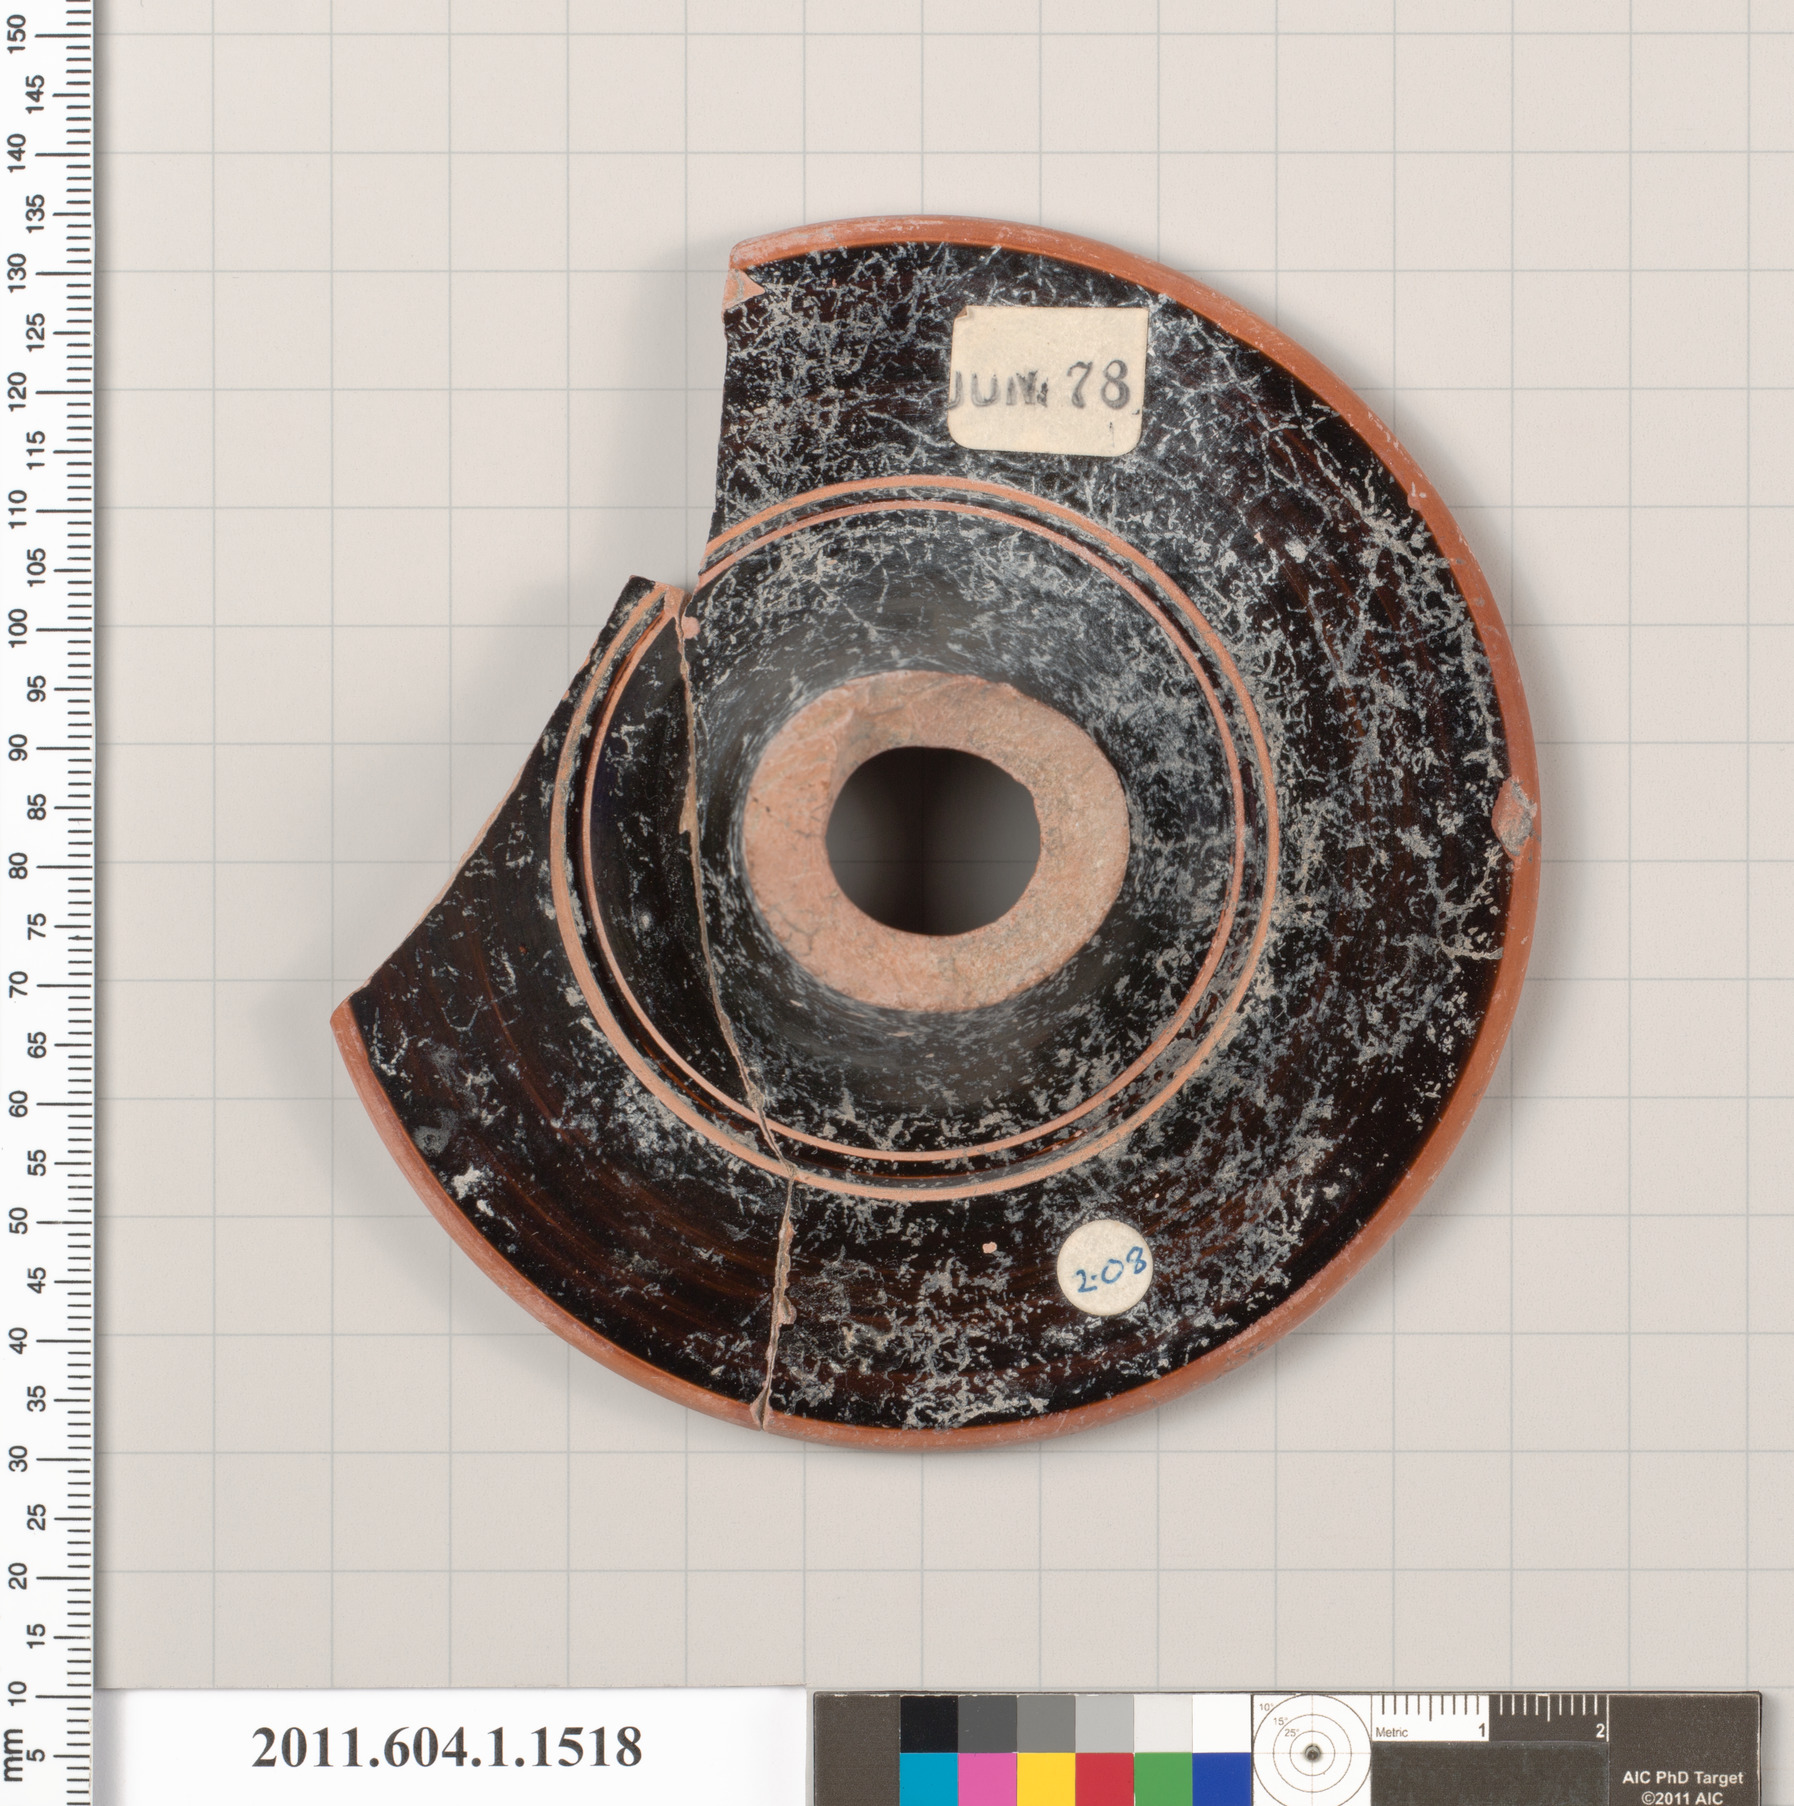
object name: kylix fragment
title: Terracotta fragment of a kylix (drinking cup)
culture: greek, attic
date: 500-401 BCE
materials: terracotta